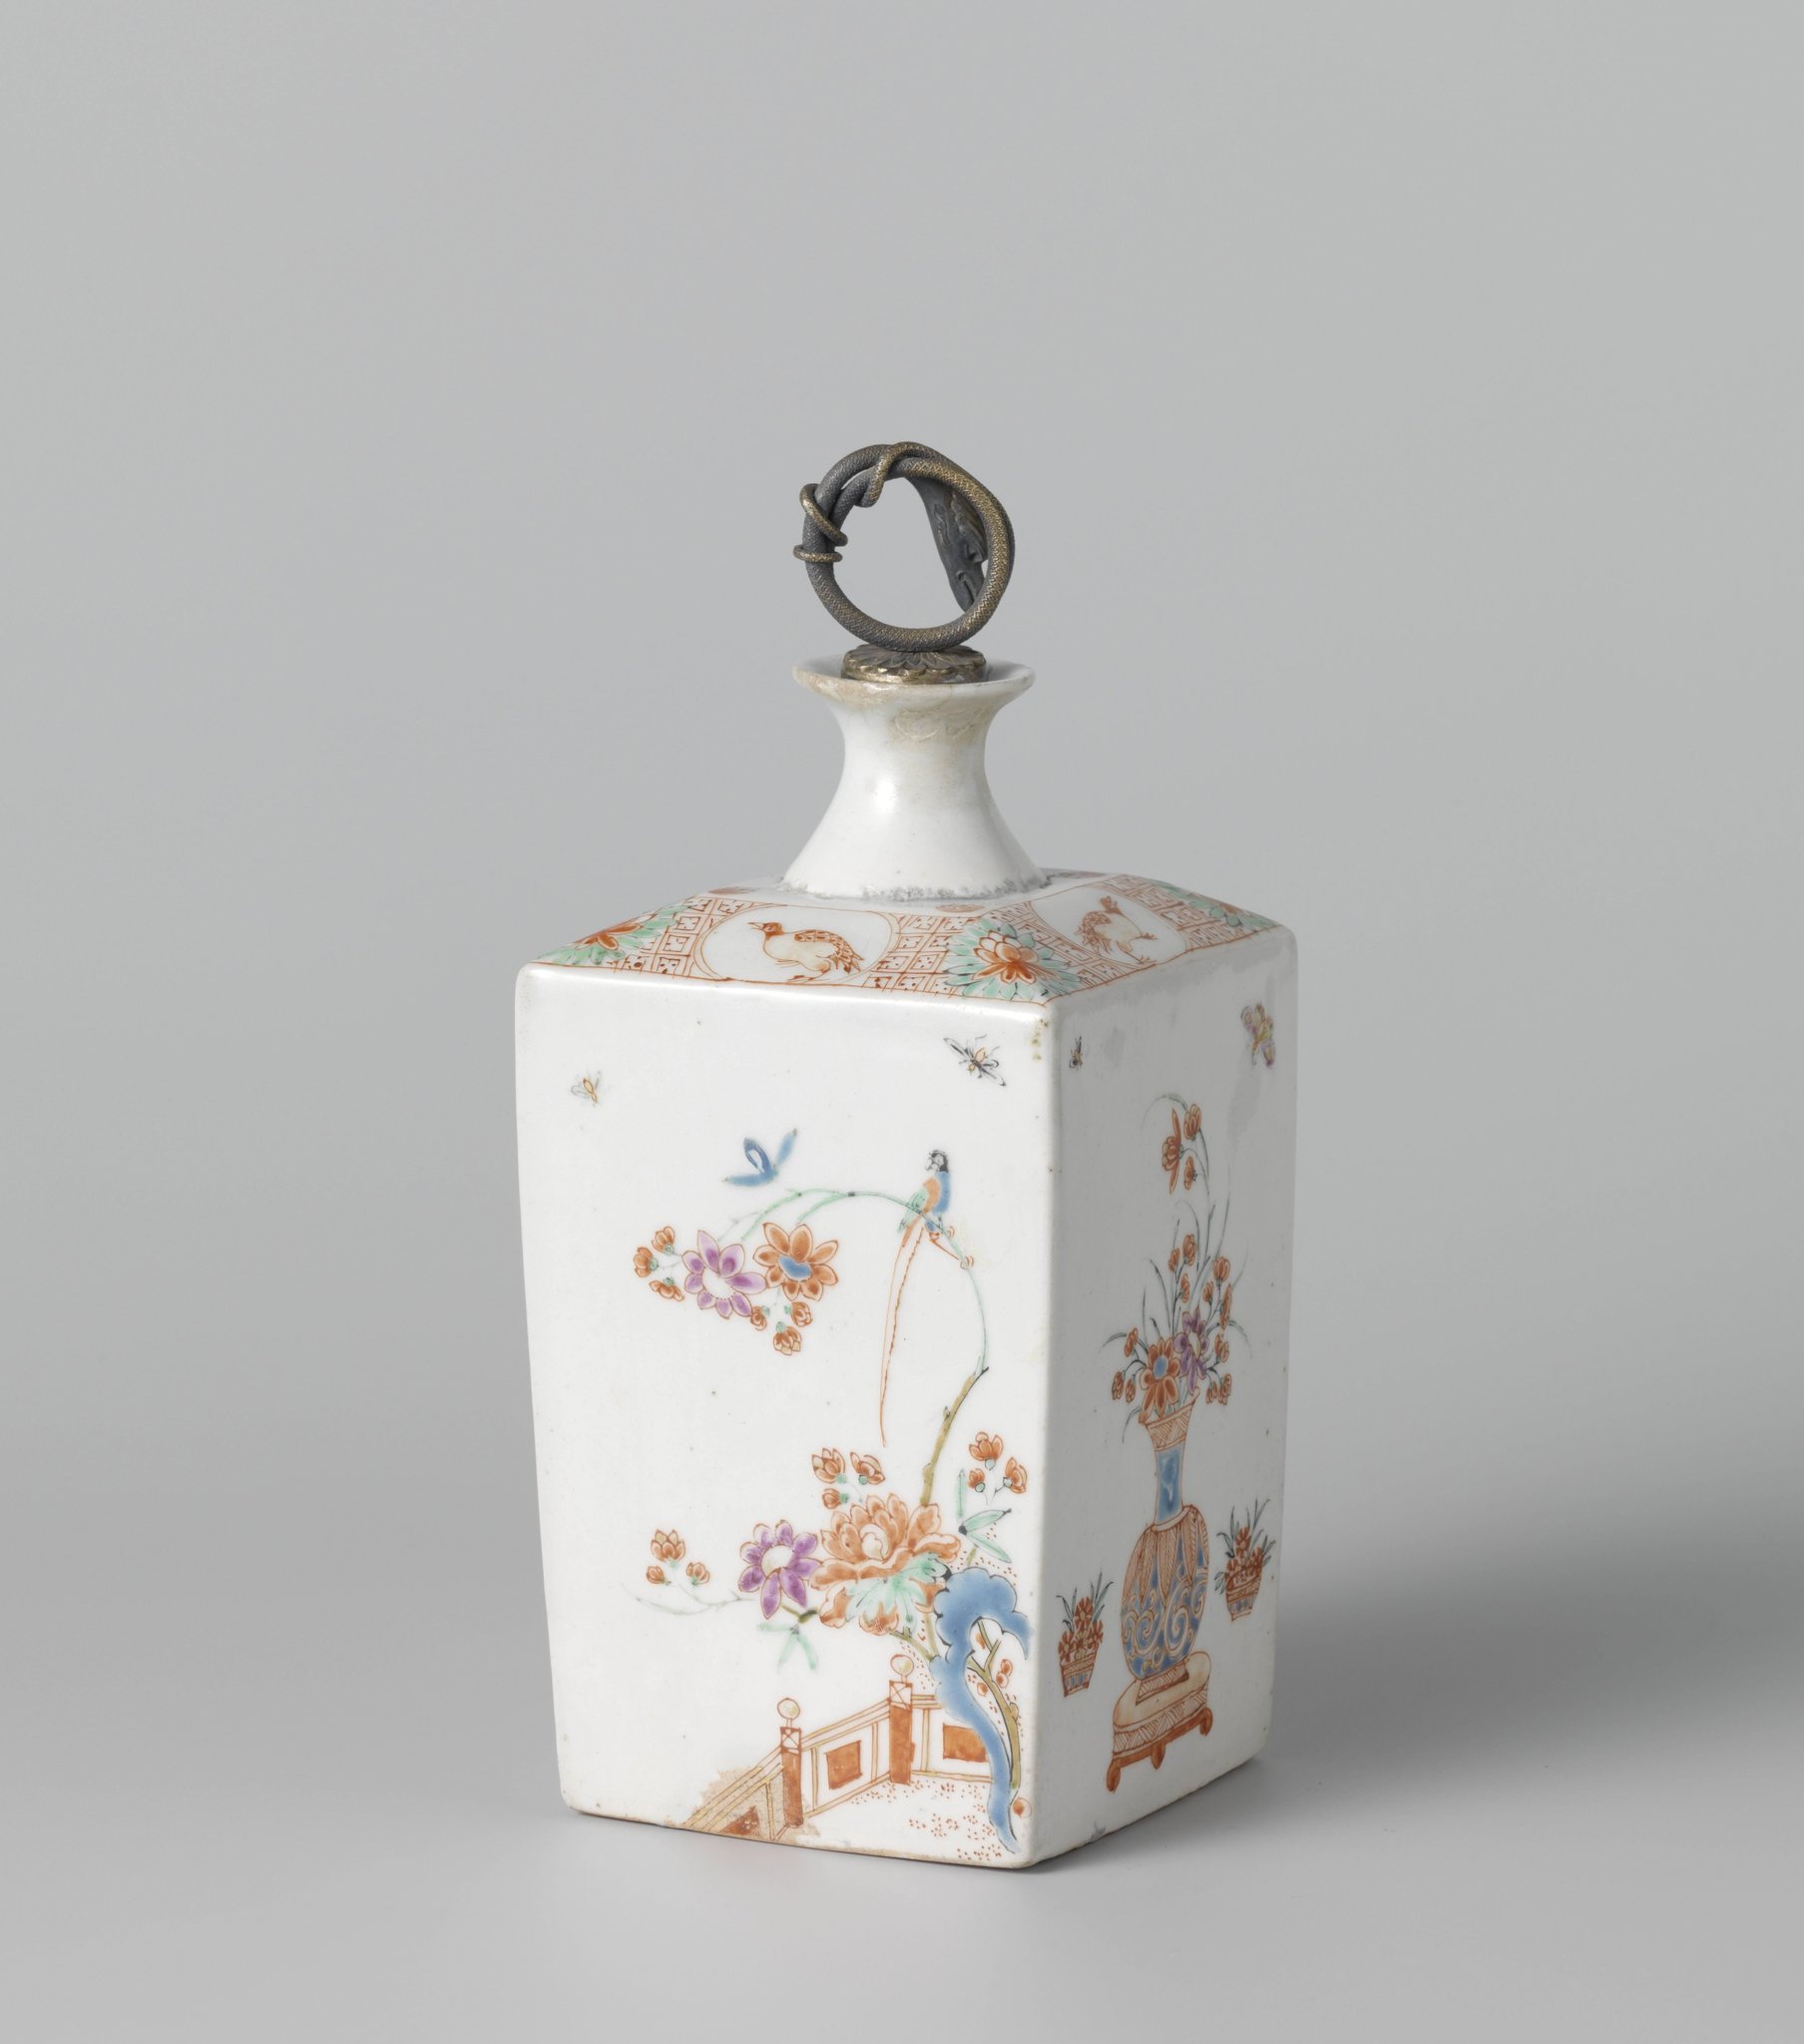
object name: bottle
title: Square bottle with flowering plants, birds, flower vases and insects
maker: Anonymous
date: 1700-1724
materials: glaze, gold, paint, porcelain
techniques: firing, gilding, relief, turning, vitrification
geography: europe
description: Pair of square flasks. Japan, c. 1700 - 1720, decorated, c. 1710 - 1725.